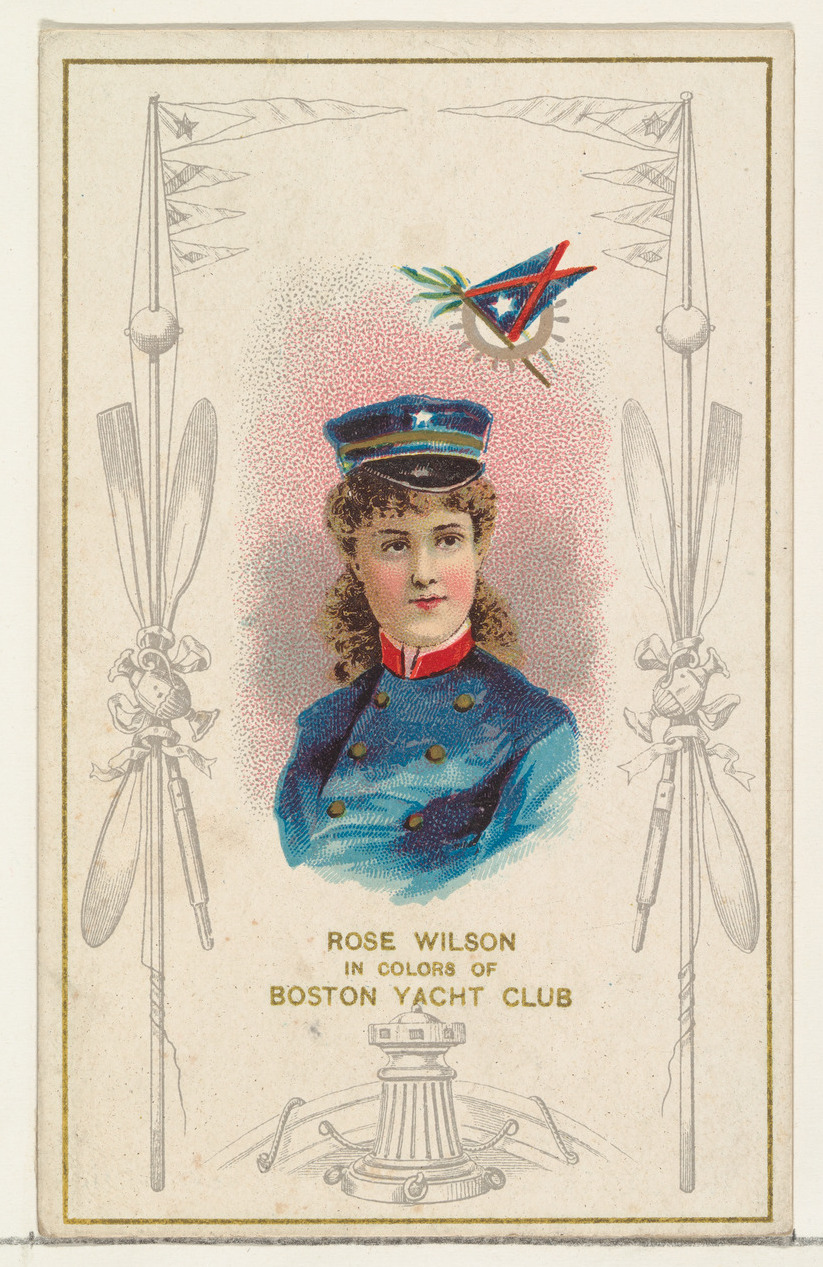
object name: print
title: Rose Wilson in Colors of the Boston Yacht Club, from the Yacht Colors of the World series (N140) issued by Duke Sons & Co. to promote Honest Long Cut Tobacco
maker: w. duke, sons & co.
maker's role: publisher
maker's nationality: american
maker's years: 1870-1920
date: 1890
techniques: color lithograph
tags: portraits,women,flags